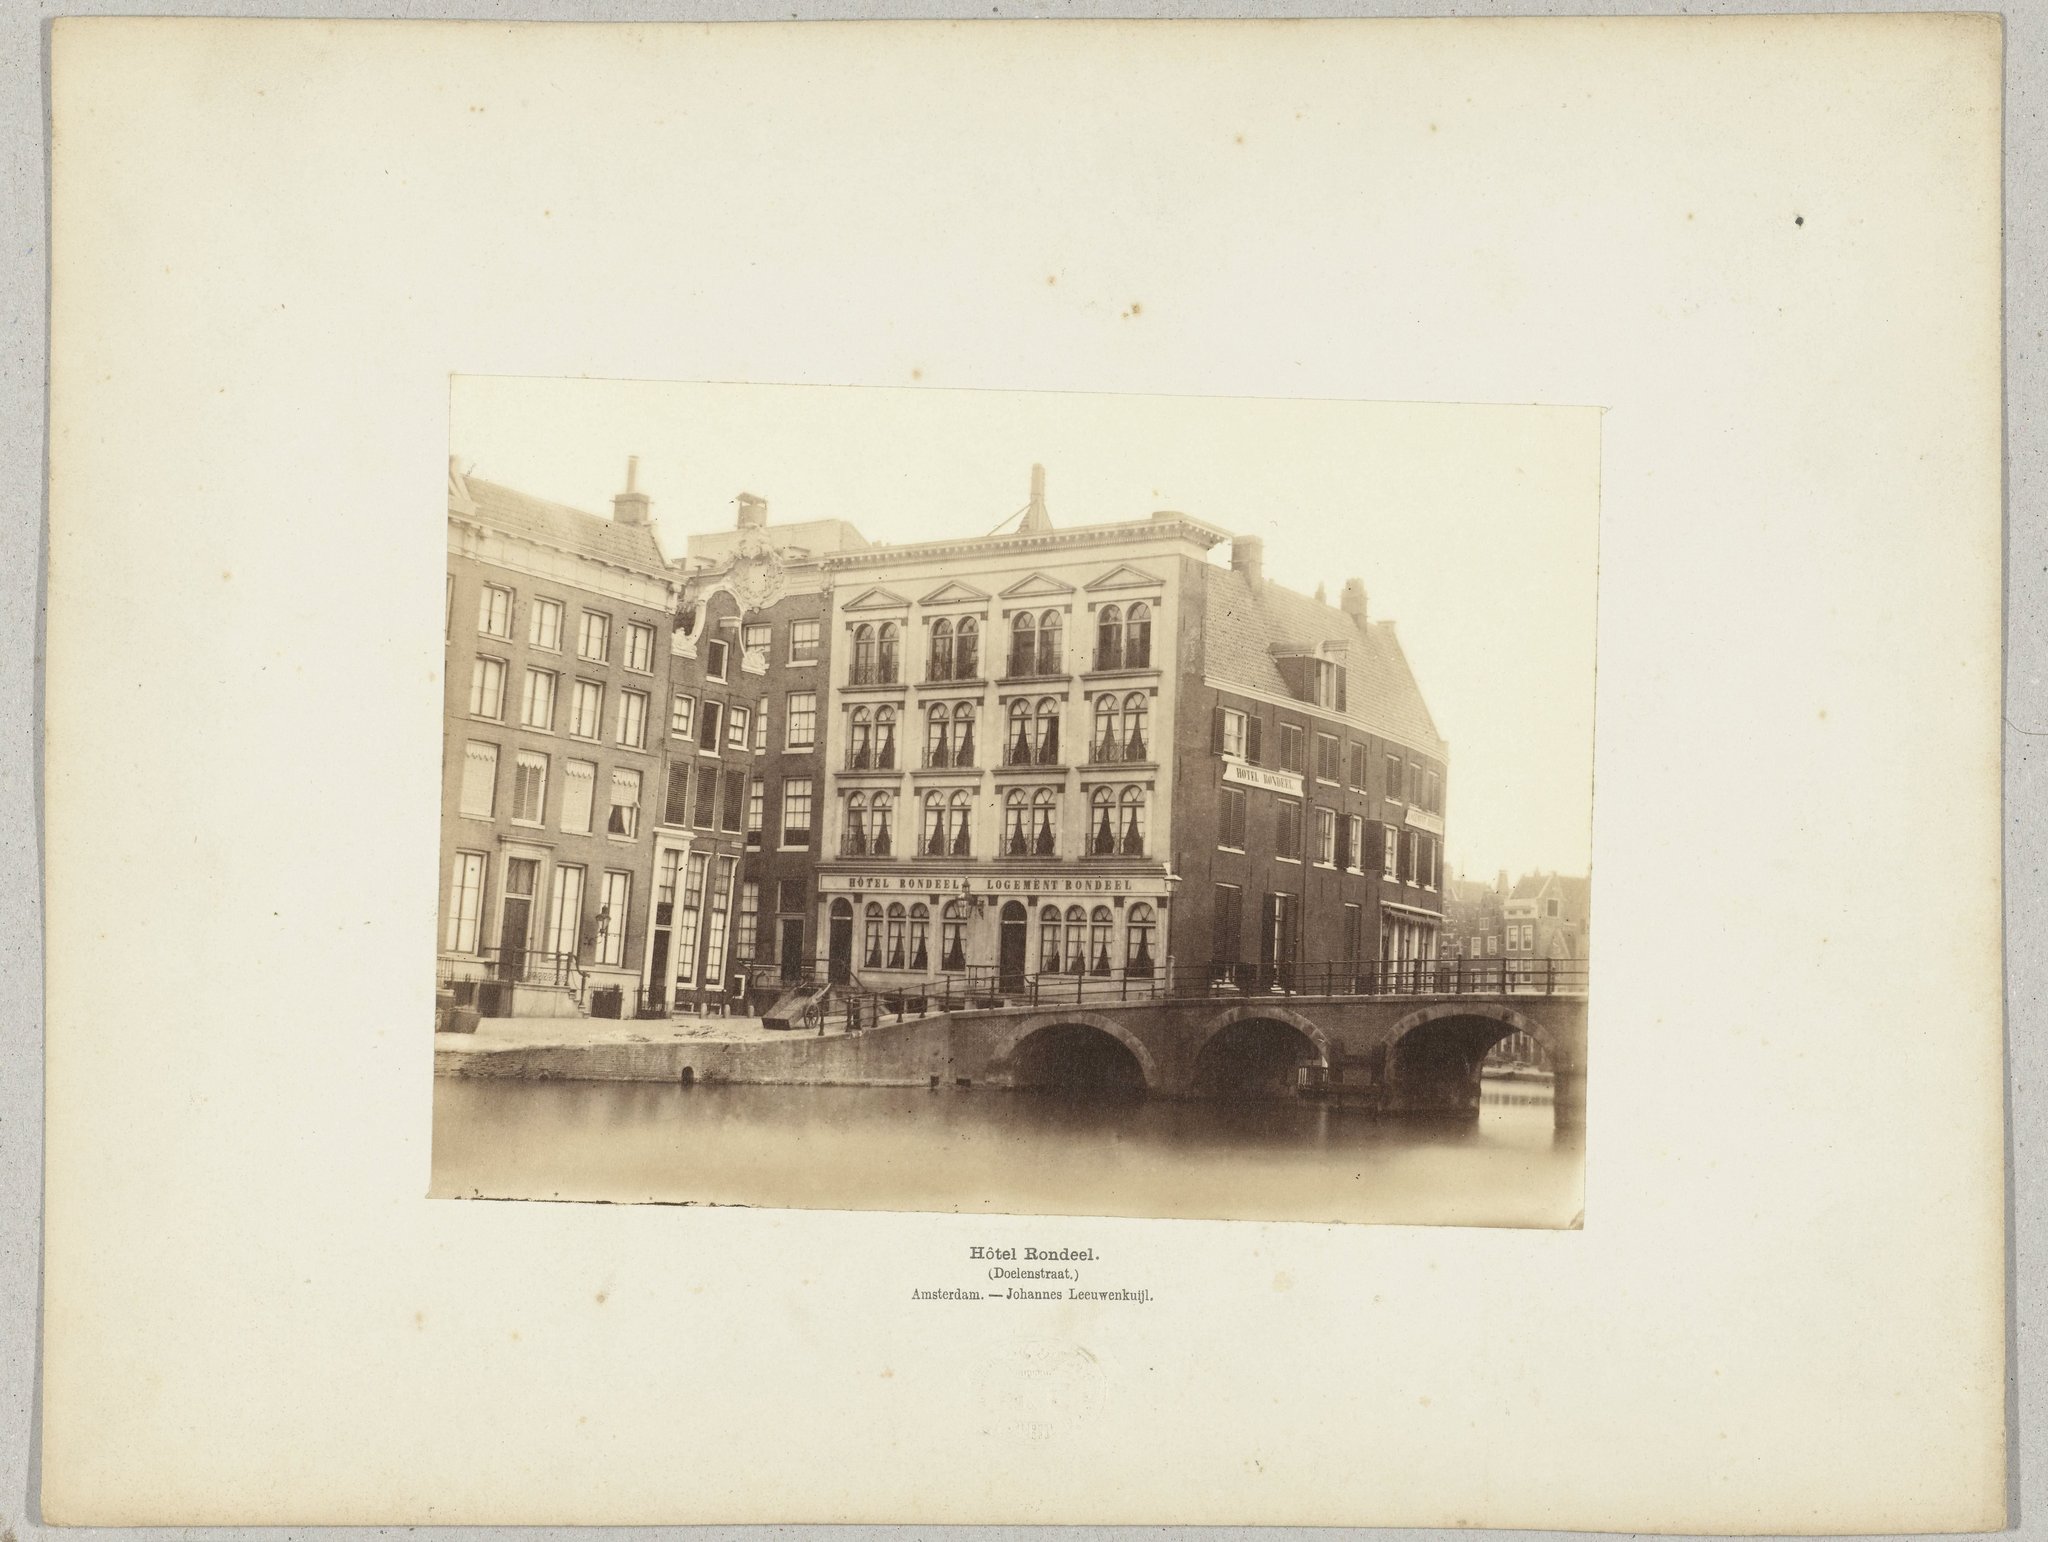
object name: photograph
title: Hotel Rondeel aan de Nieuwe Doelenstraat te Amsterdam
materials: cardboard, paper, photographic support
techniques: albumen print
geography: haarlem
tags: hotel, hostelry, inn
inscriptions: check stamp: ‘M & E photographie Haarlem’